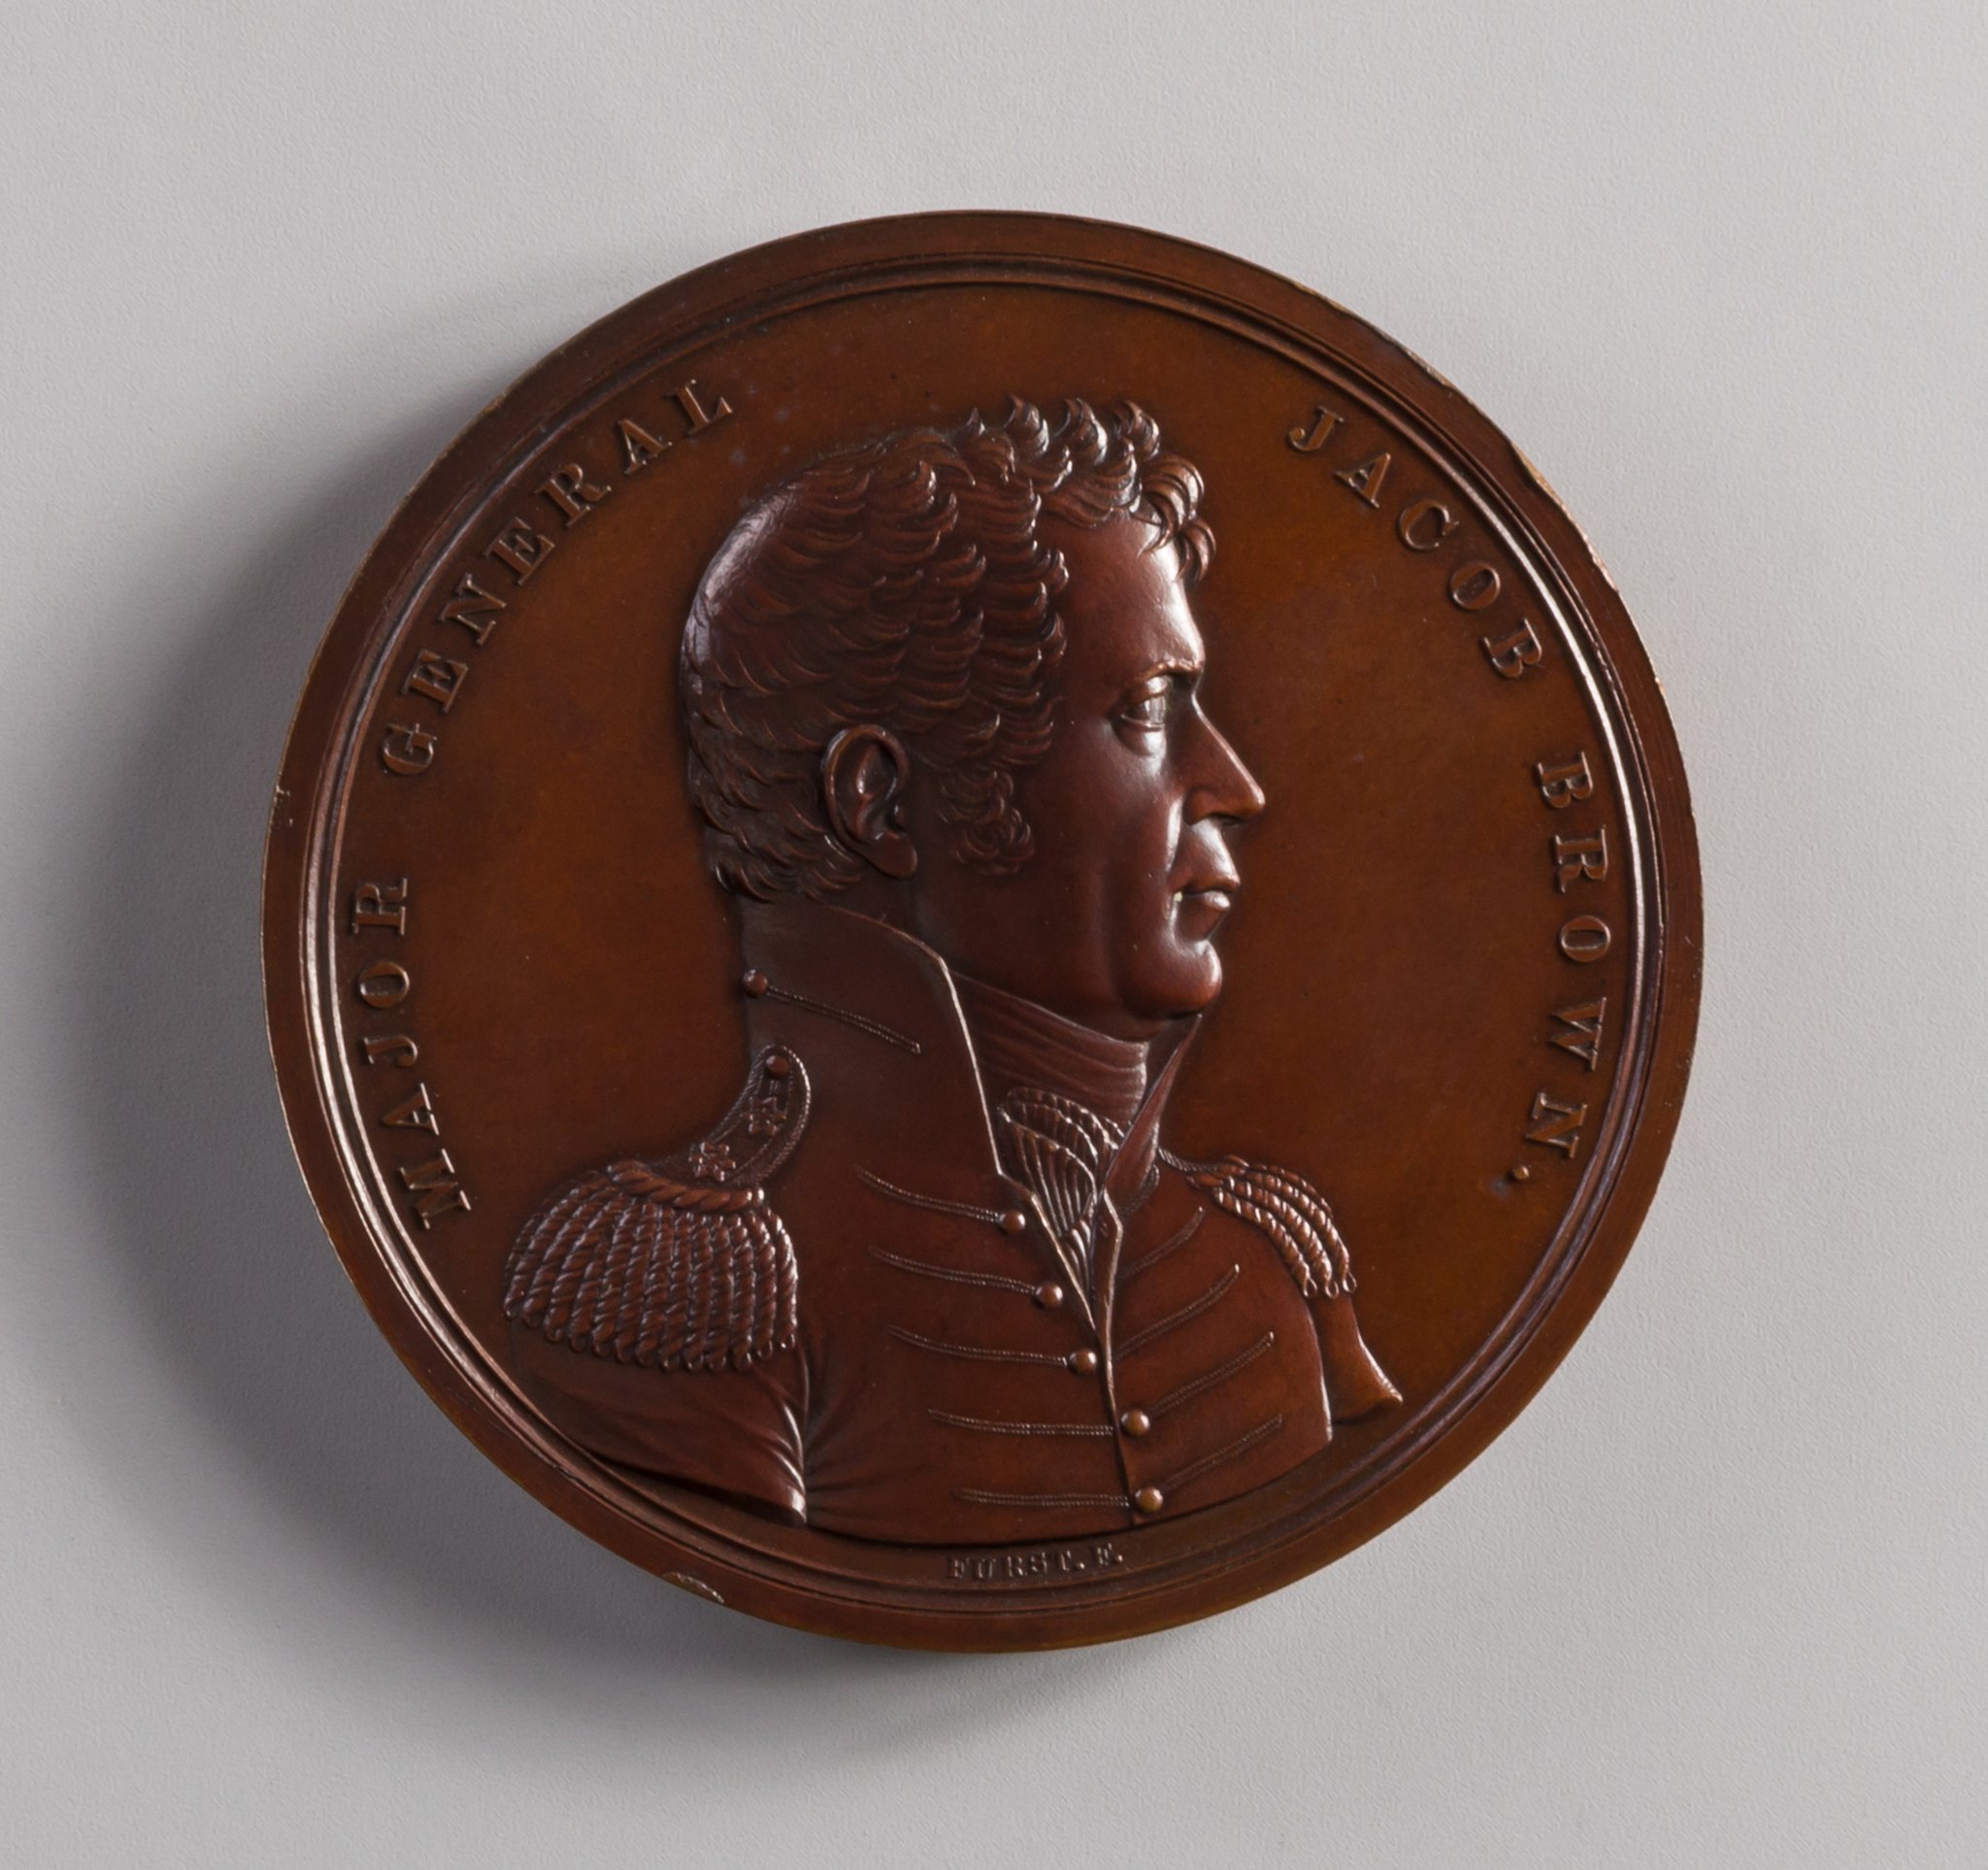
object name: medal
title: Medal of Major General Jacob Brown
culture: american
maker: moritz fürst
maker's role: maker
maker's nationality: hungarian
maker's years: 1782-1882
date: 1800-1830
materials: bronze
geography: united states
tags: men,profiles